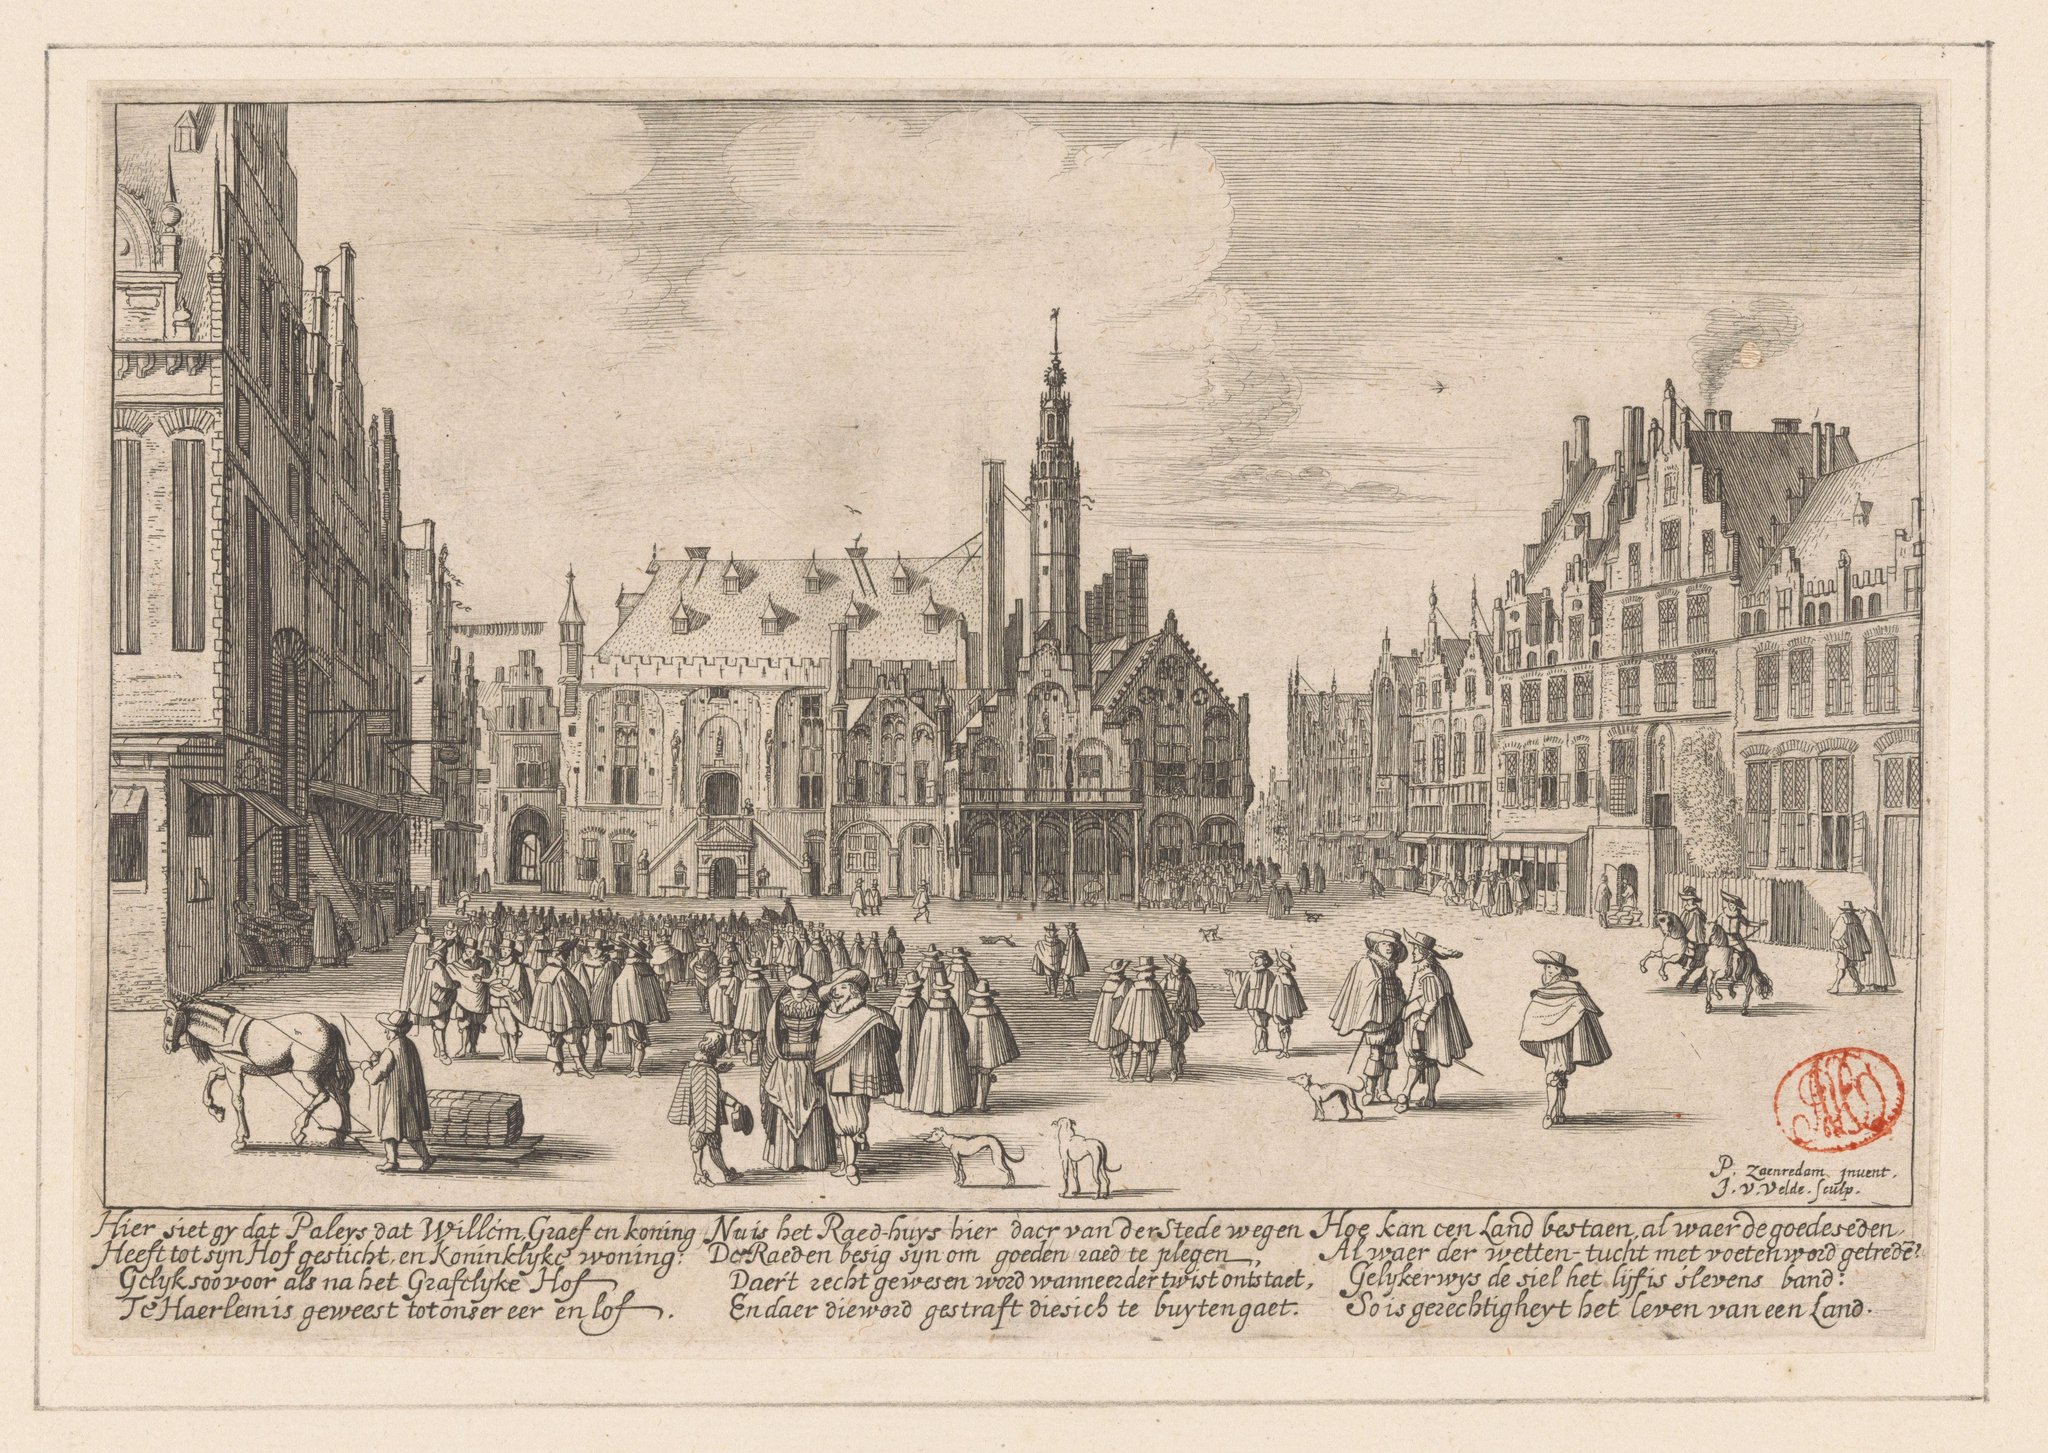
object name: book illustration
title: Gezicht op de Grote Markt met het stadhuis te Haarlem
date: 1628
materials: paper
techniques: engraving, etching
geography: haarlem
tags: townhall, market, square, place, circus, etc. (+ city(-scape) with figures, staffage)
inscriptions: collector's mark: Lugt 195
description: Prent ook gebruikt in: Ampzing, Samuel. Beschryvinge ende lof der stad Haerlem in Holland (…). Haarlem: Adriaen Roman (I), 1628.